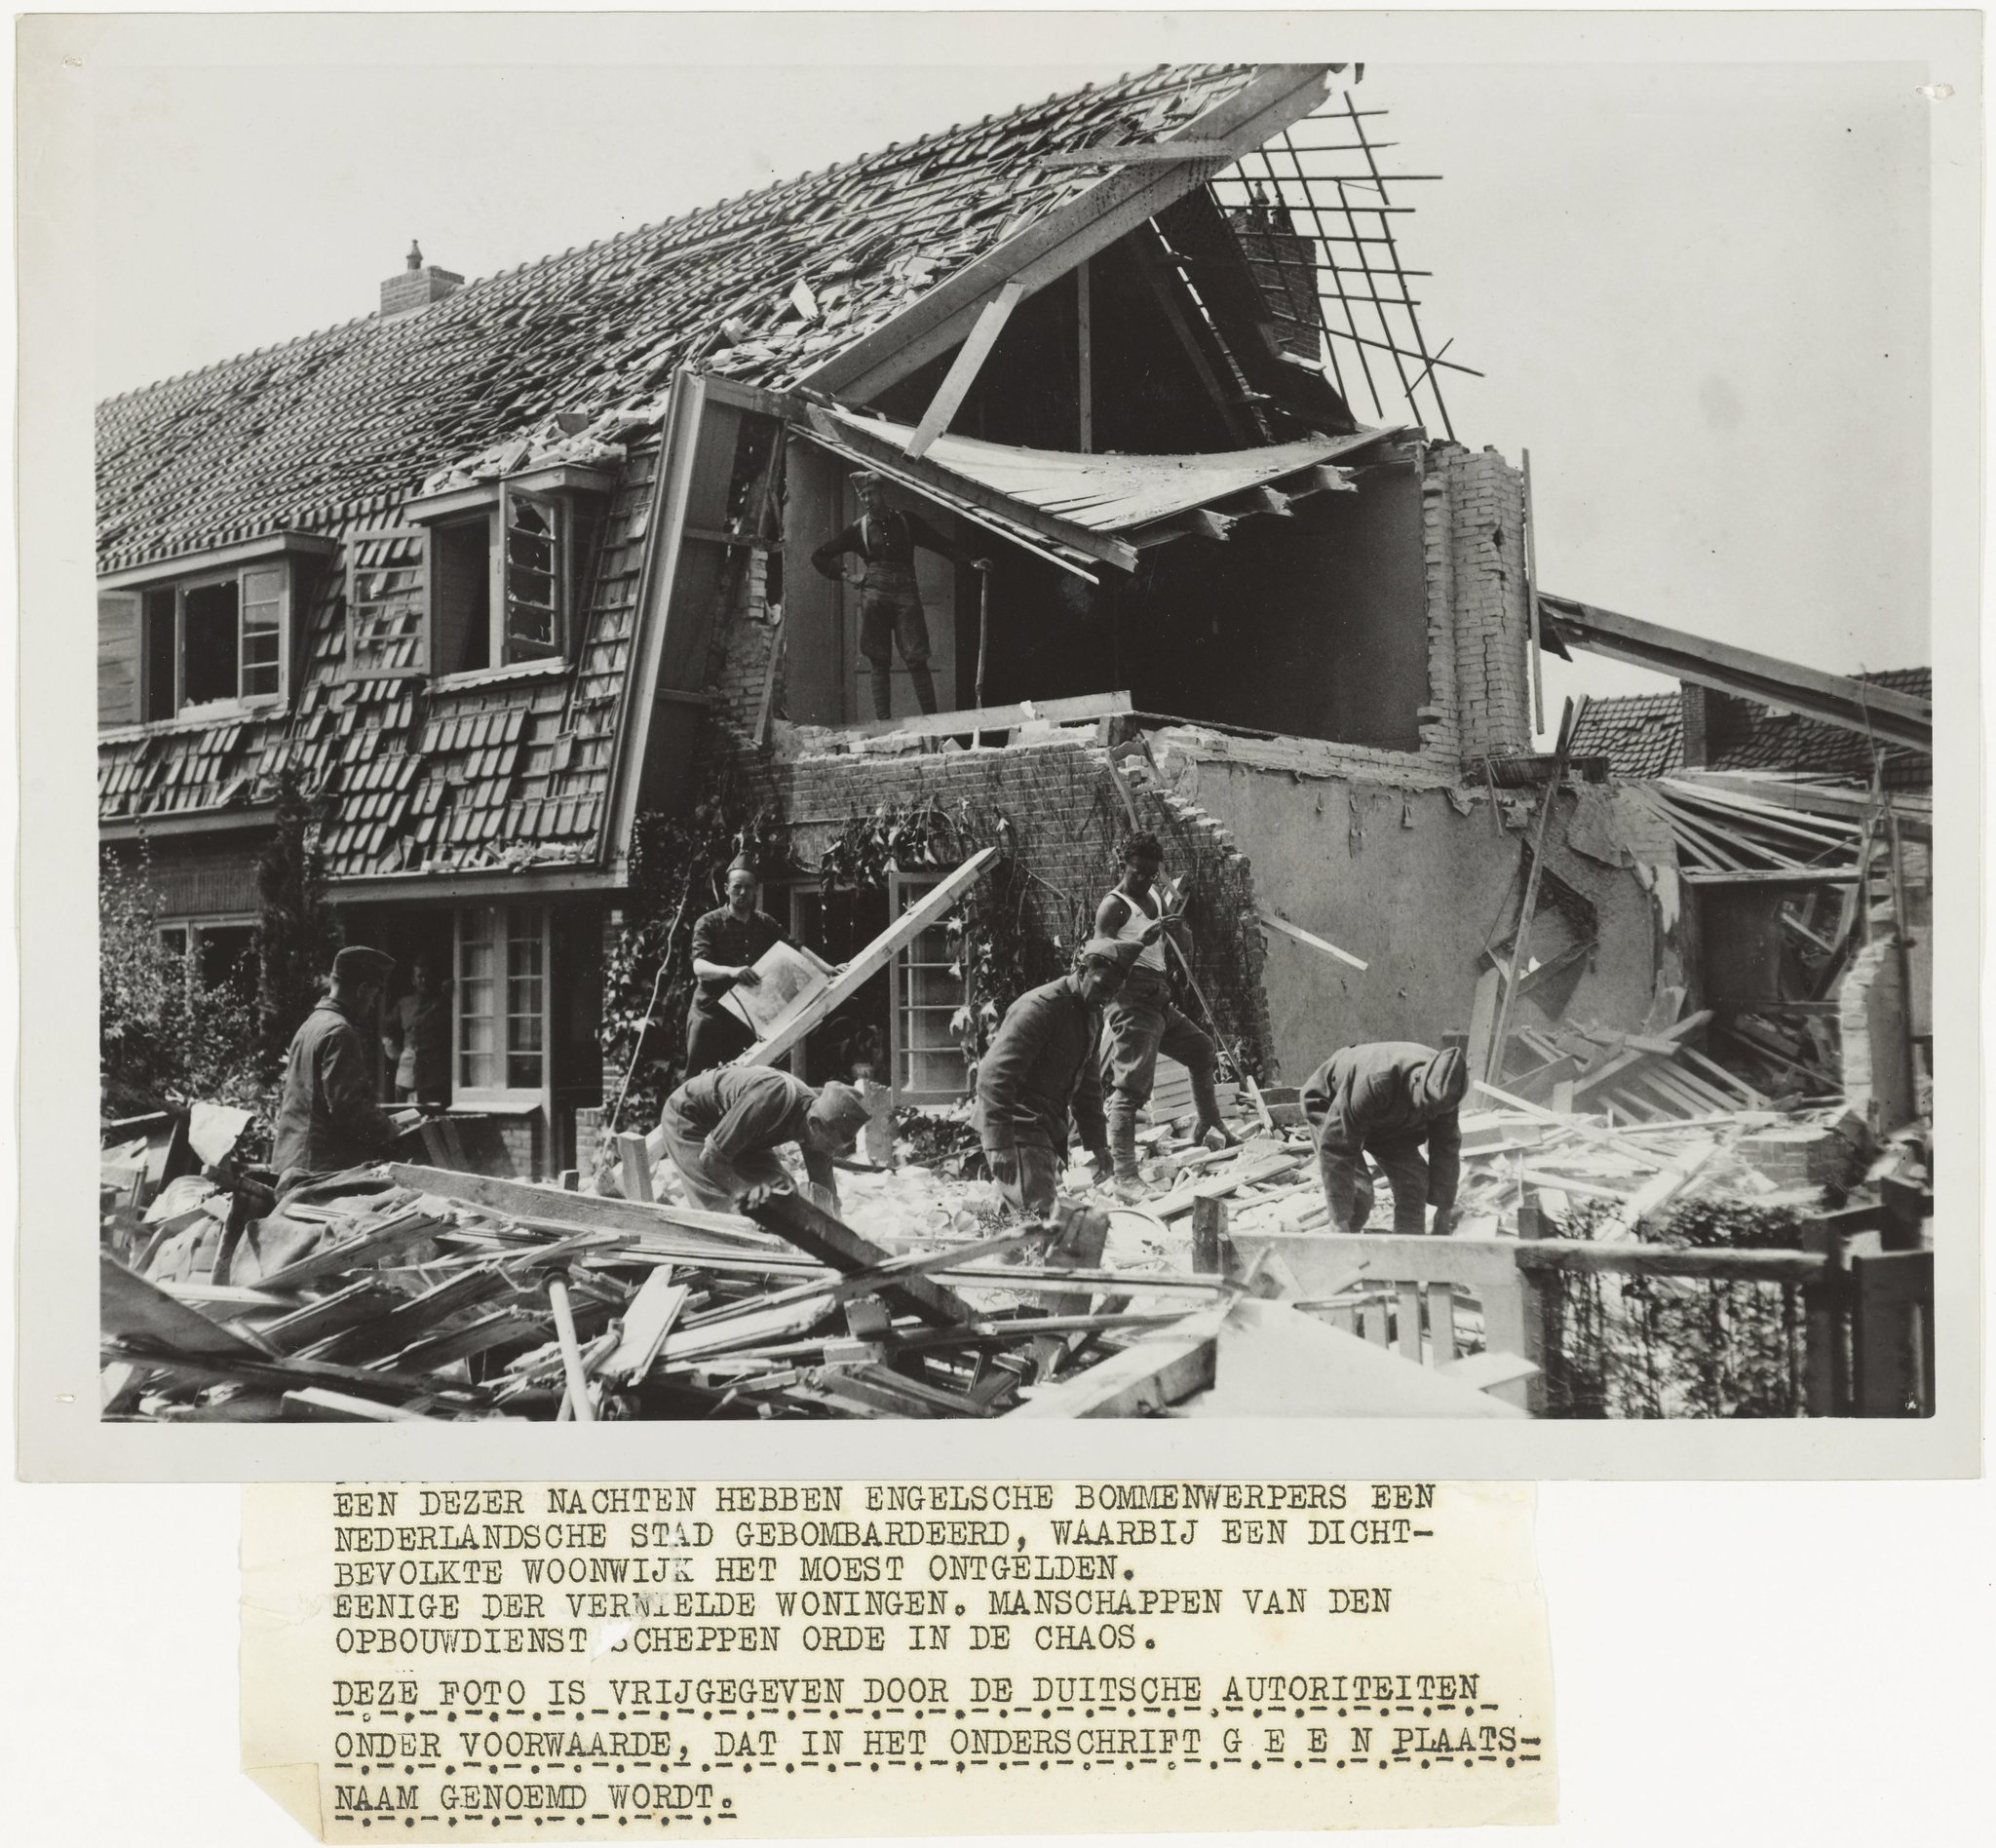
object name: photograph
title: Huizen getroffen door Engelse bommen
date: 1940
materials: photographic support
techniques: photography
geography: netherlands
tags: devastated, ruined place or city (~ warfare), netherlands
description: Huizen in een dichtbevolkte woonwijk zijn getroffen door Engelse bommenwerpers 'ergens in Nederland', aldus het bijschrift. Tekststrookje aan foto geplakt.